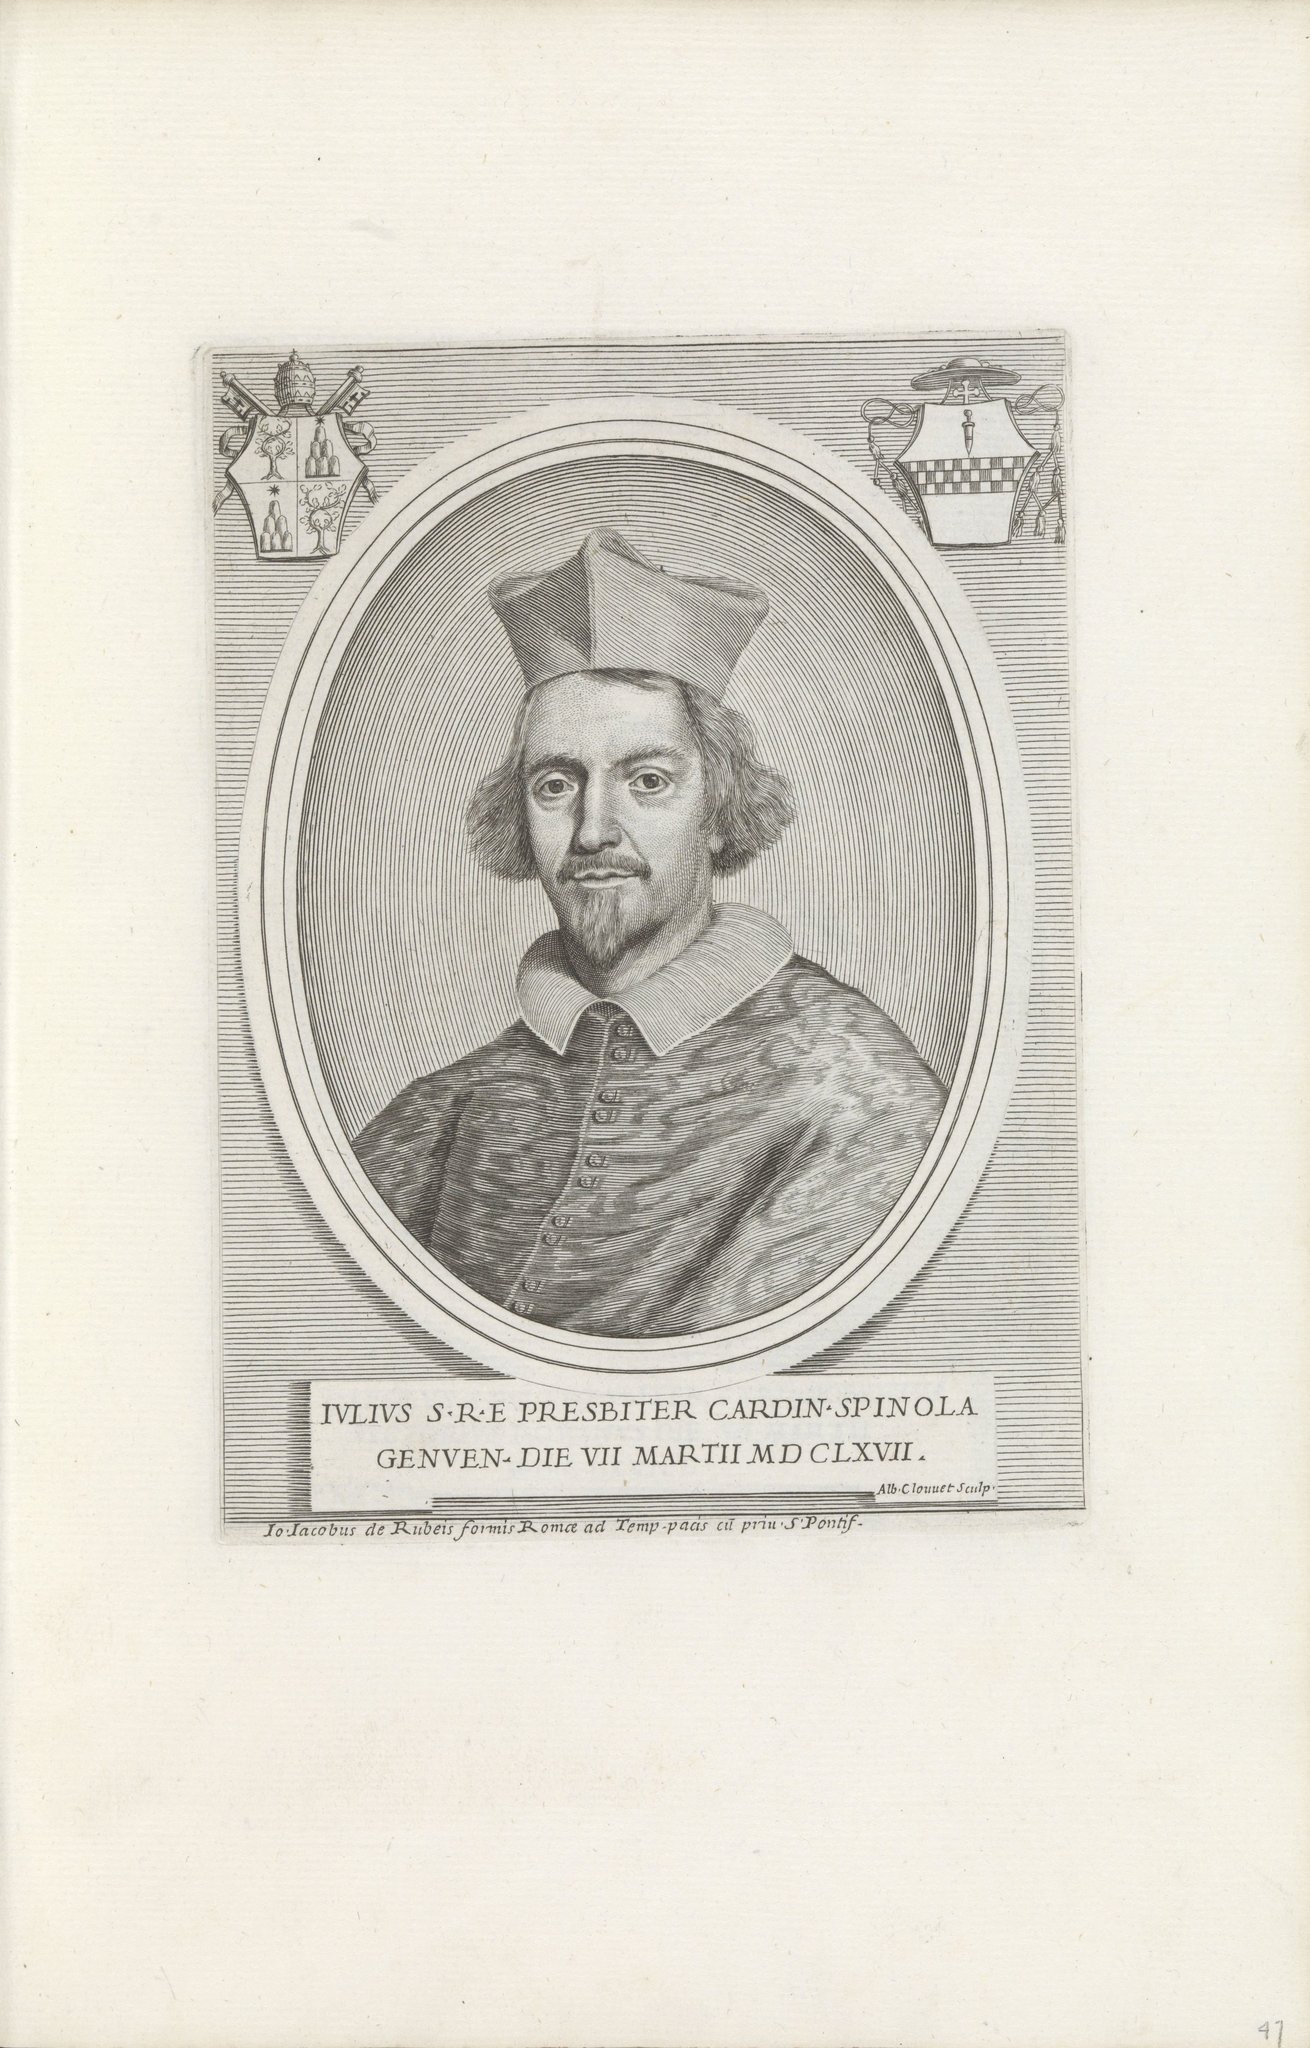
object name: album leaf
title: Effigies Nomina et Cognomina S.D.N. Alexandri Papae VII et RR. DD. SRE. Cardd (...).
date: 1667-1679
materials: paper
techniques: engraving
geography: rome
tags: rome, cardinal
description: Portret van kardinaal Giulio Spinola. Linksboven het wapen van paus Alexander VII en rechtsboven het wapen van de kardinaal. Onderaan een onderschrift in het Latijn. De prent maakt deel uit van een album.